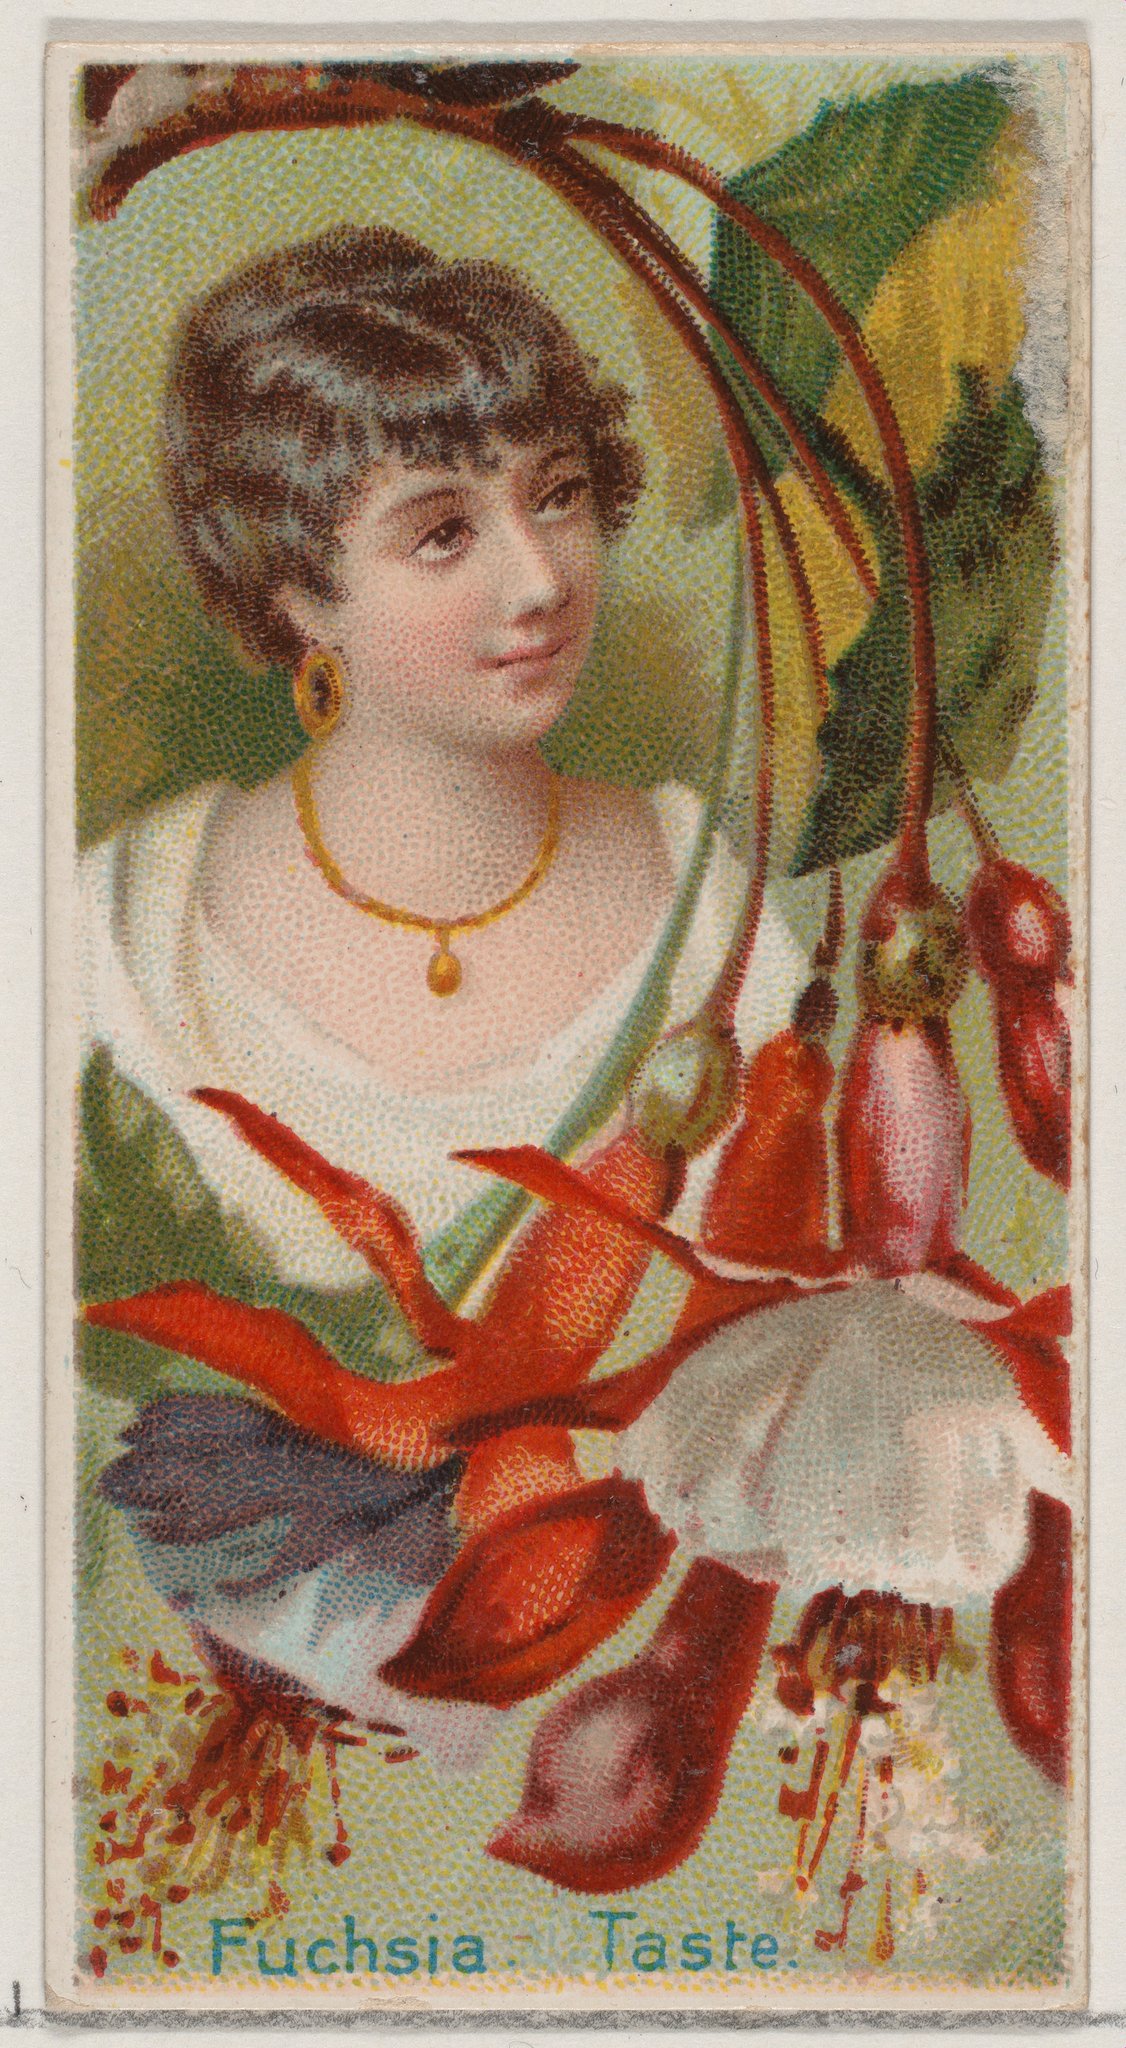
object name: print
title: Fuchsia: Taste, from the series Floral Beauties and Language of Flowers (N75) for Duke brand cigarettes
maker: american tobacco company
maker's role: publisher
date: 1892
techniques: color lithograph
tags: women,flowers